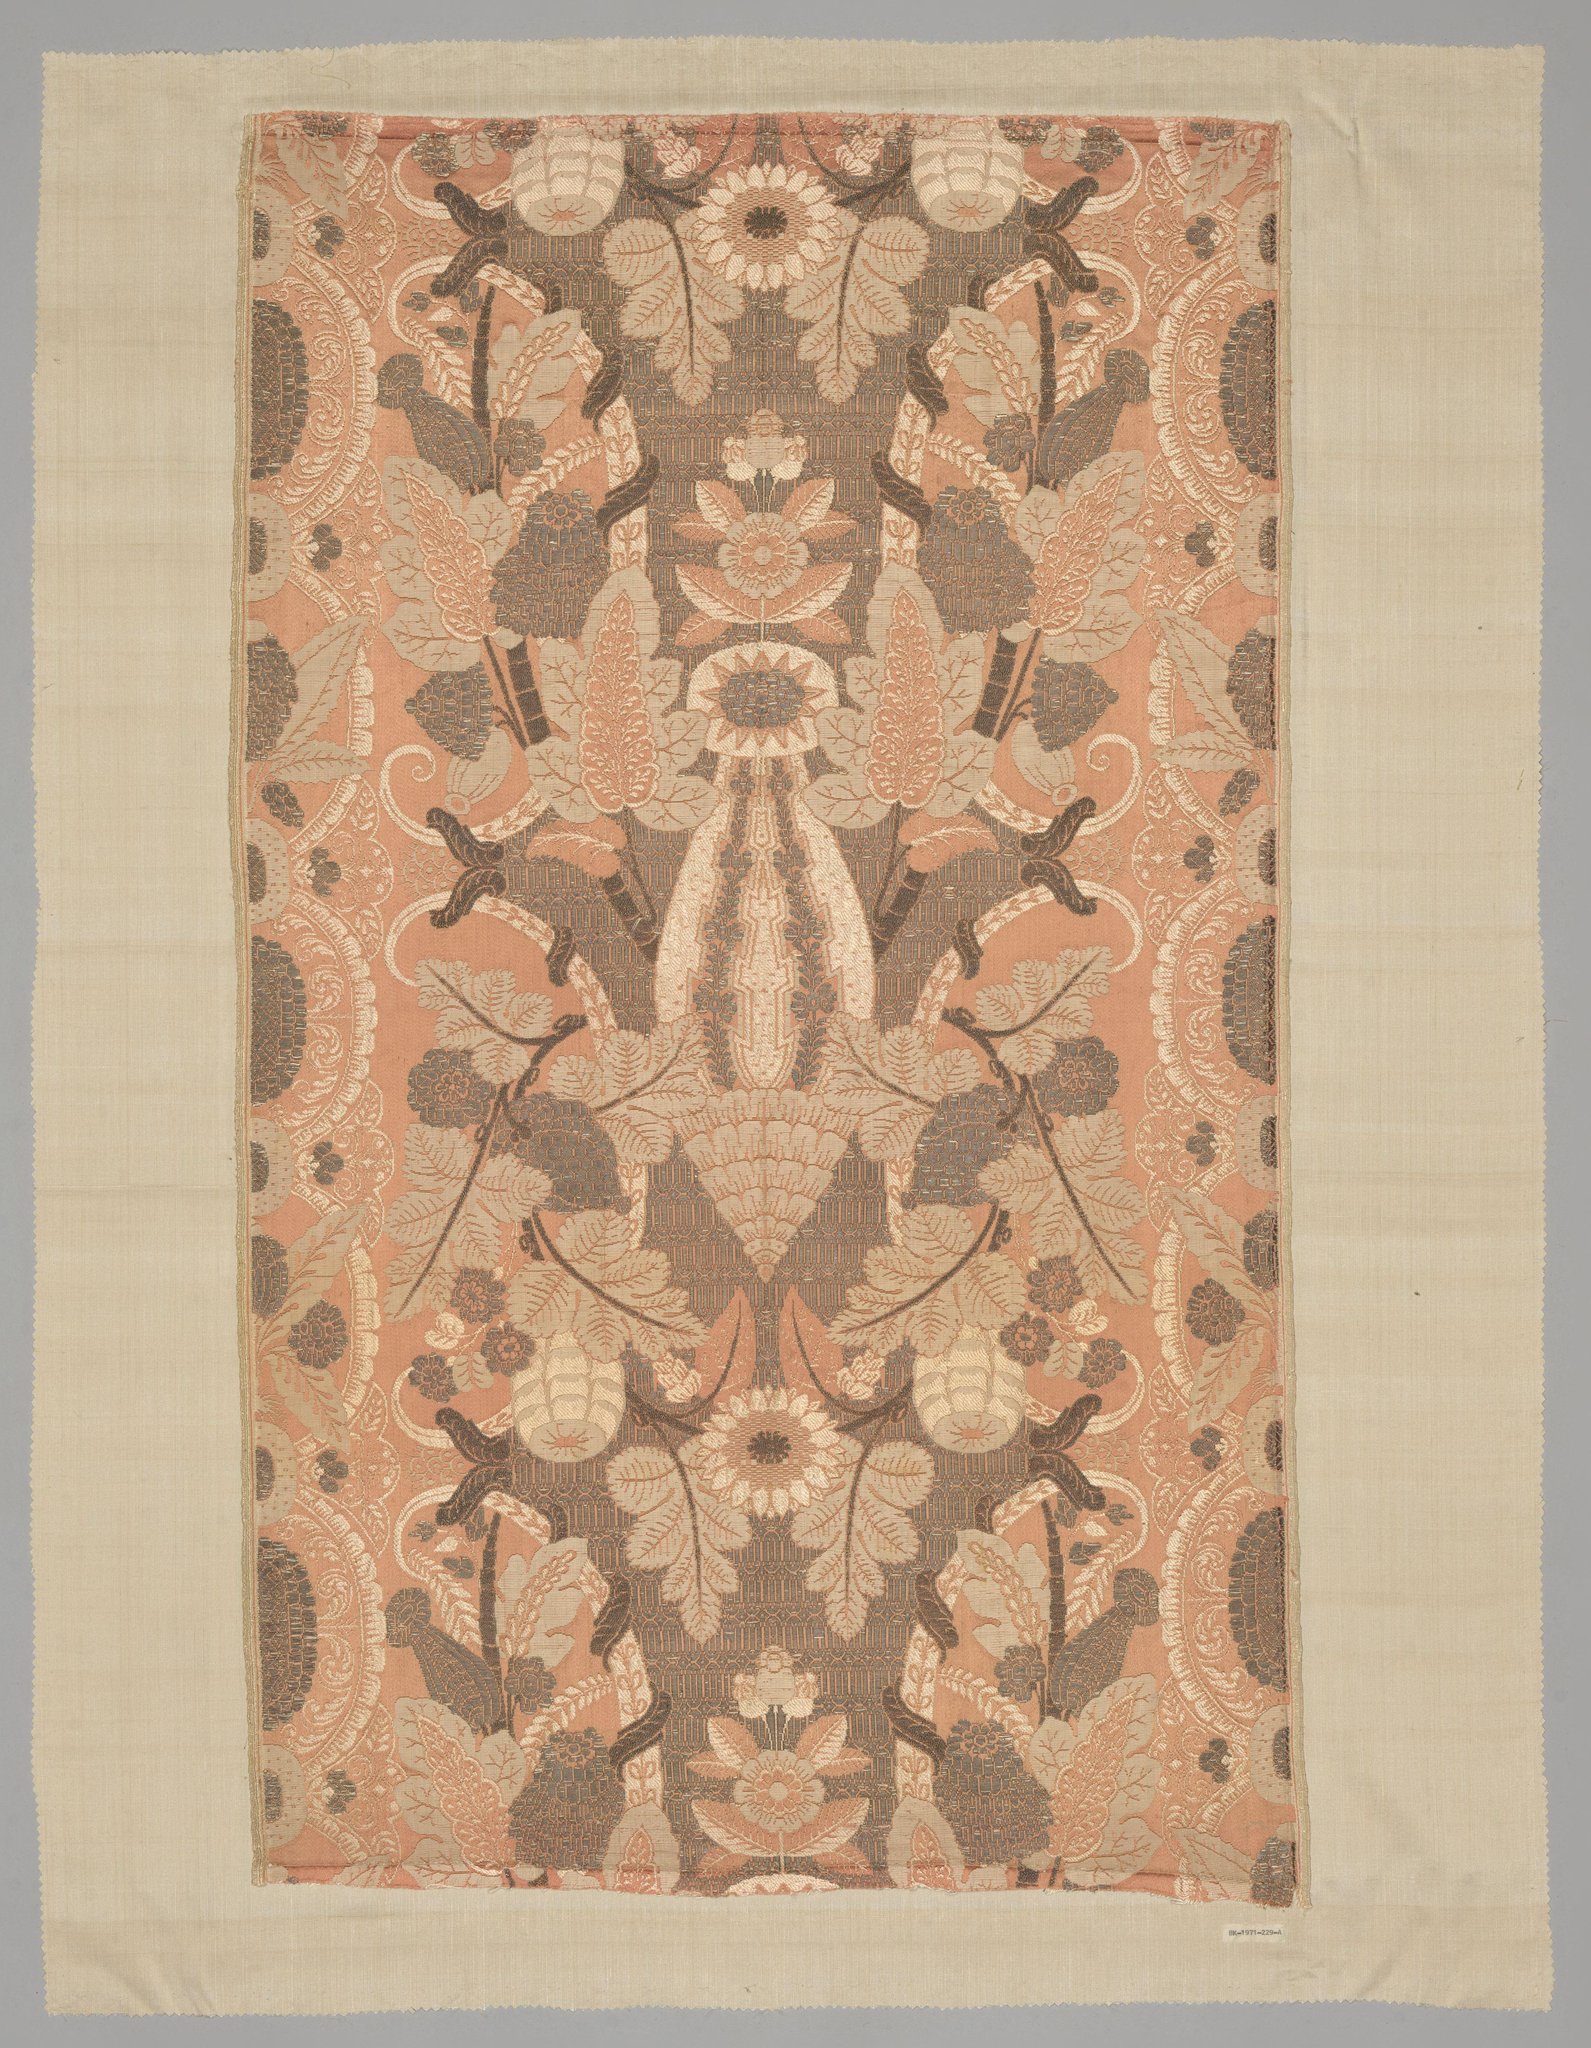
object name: silk textile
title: Zijden brokaat met een 'kantpatroon'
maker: Anonymous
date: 1720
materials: silk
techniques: brocade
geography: france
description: Zijden brocaat met een 'kantpatroon'. Naturelkleurige en lichtbruine zijde en zilverkleurig metaaldraad (deels frisé). Op linnen gezet.